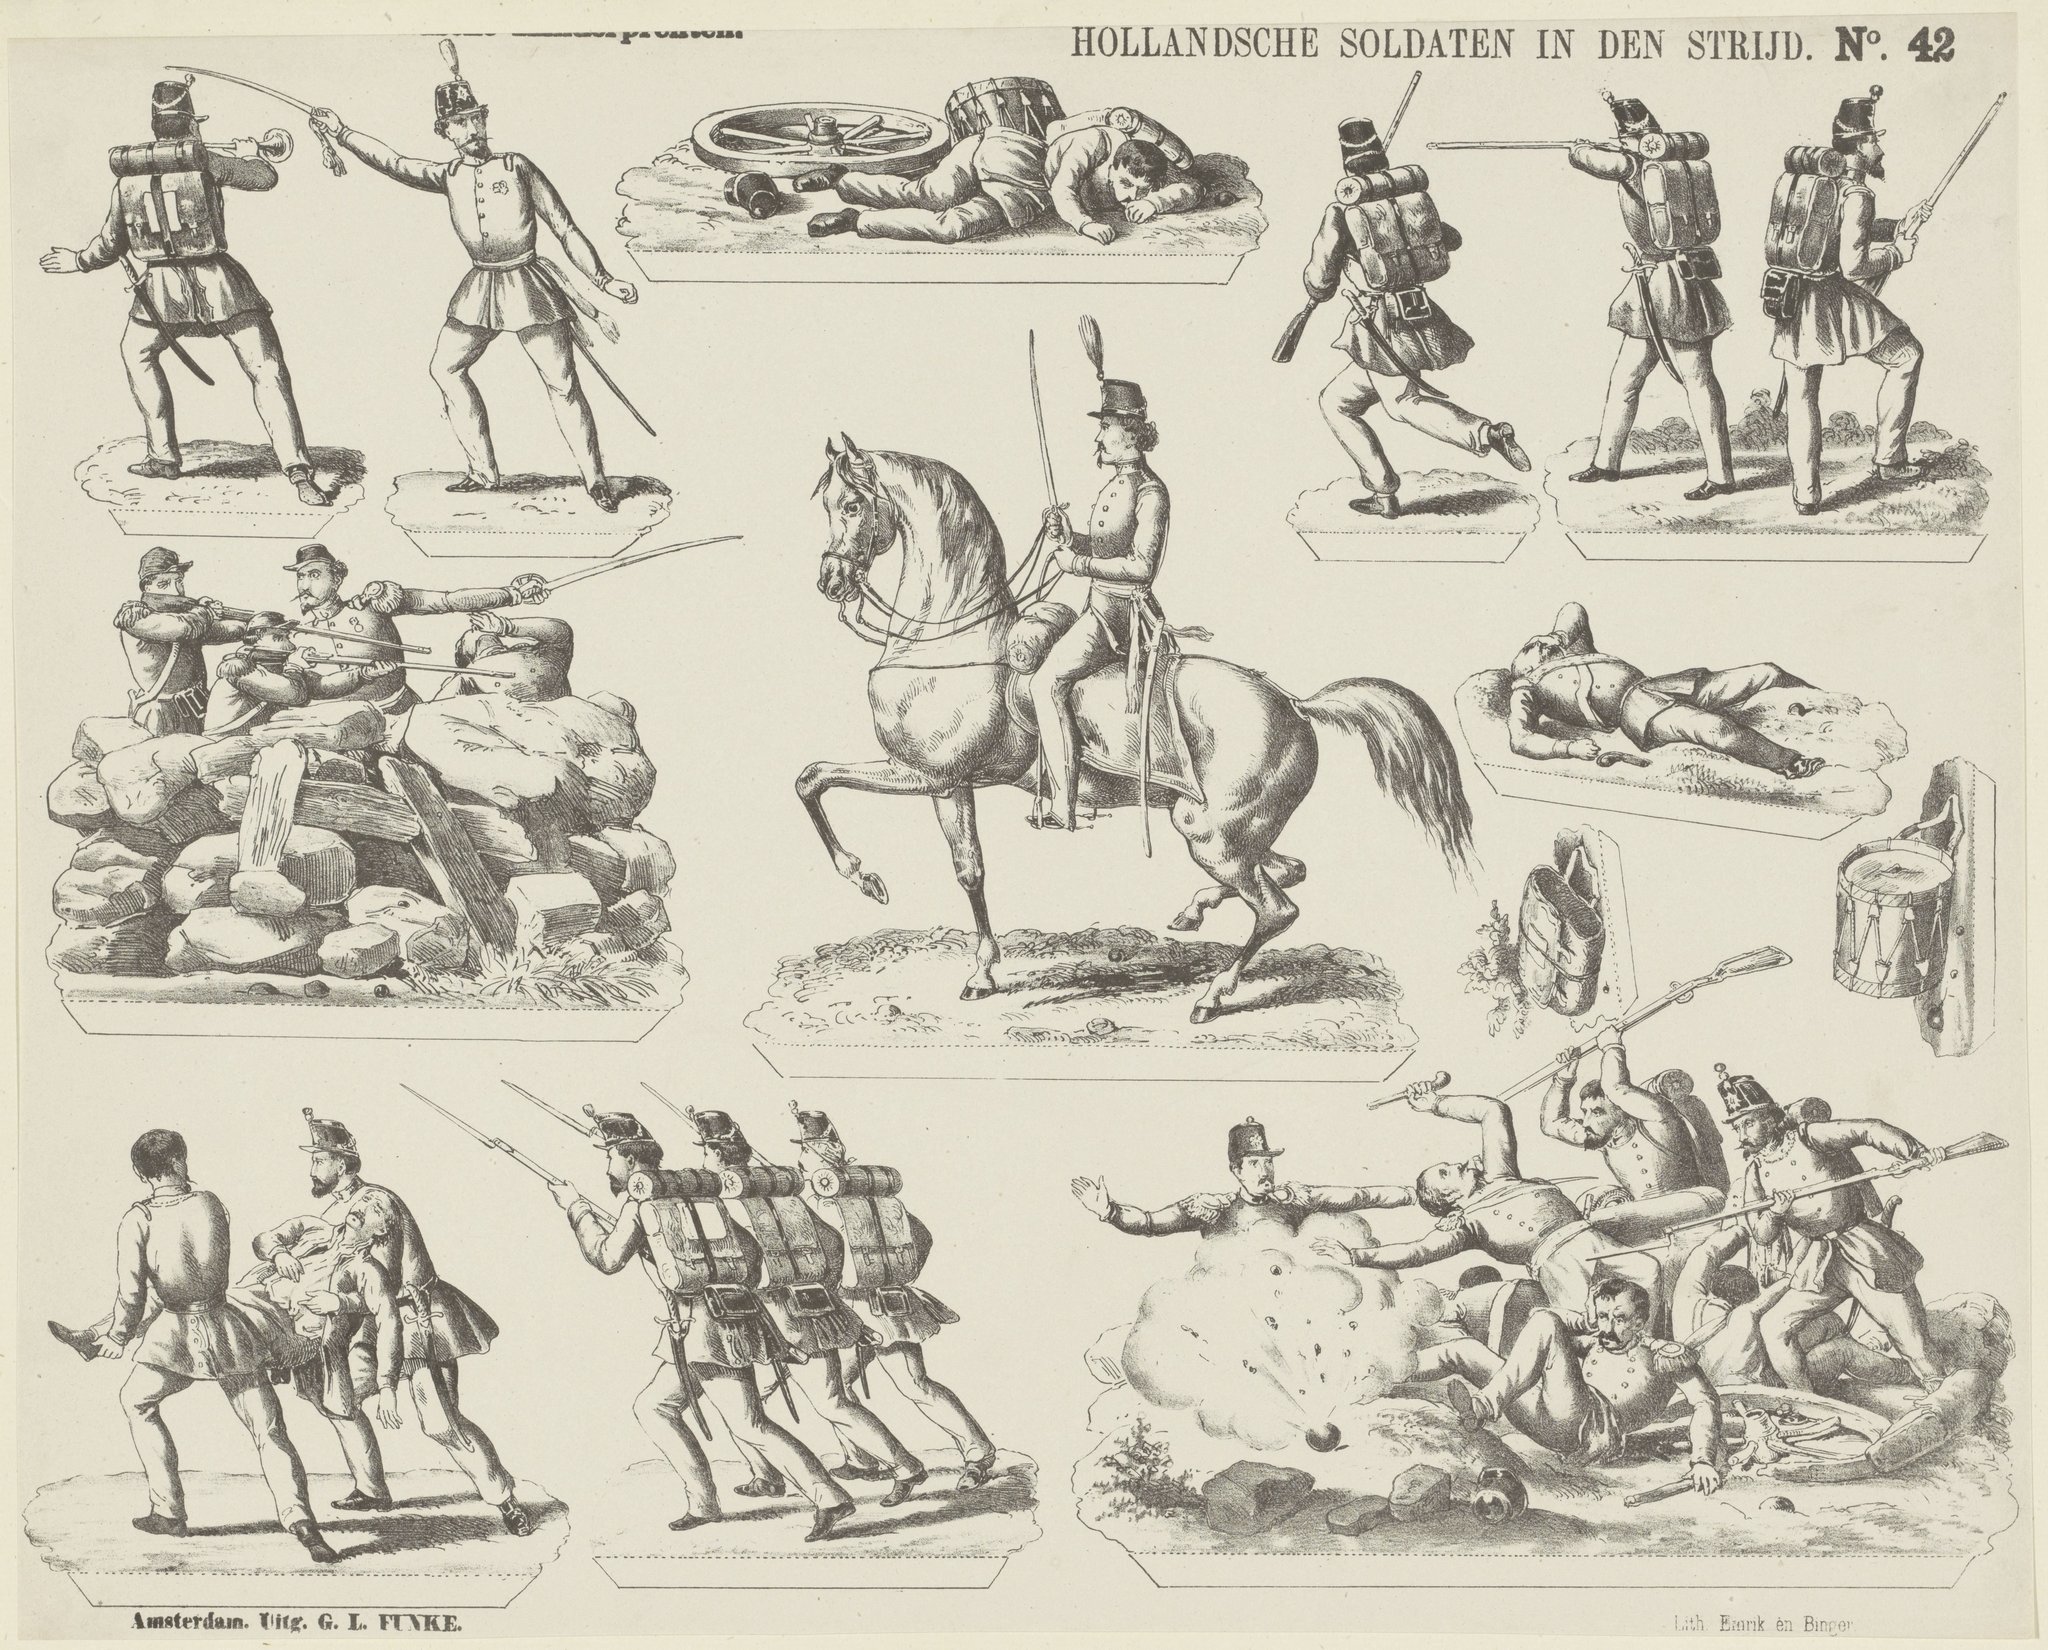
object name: popular print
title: Hollandsche soldaten in den strijd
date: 1865-1875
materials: paper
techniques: letterpress printing, lithograph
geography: amsterdam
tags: transport of the sick, wounded and dead (military) (+ privates), weapons, warfare; military affairs (+ cavalry, horsemen), the soldier; the soldier's life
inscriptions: collector's mark: Lugt 2760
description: Blad met 13 voorstellingen van soldaten, bepakking en een trom om uit te knippen. Genummerd rechtsboven: No. 42.